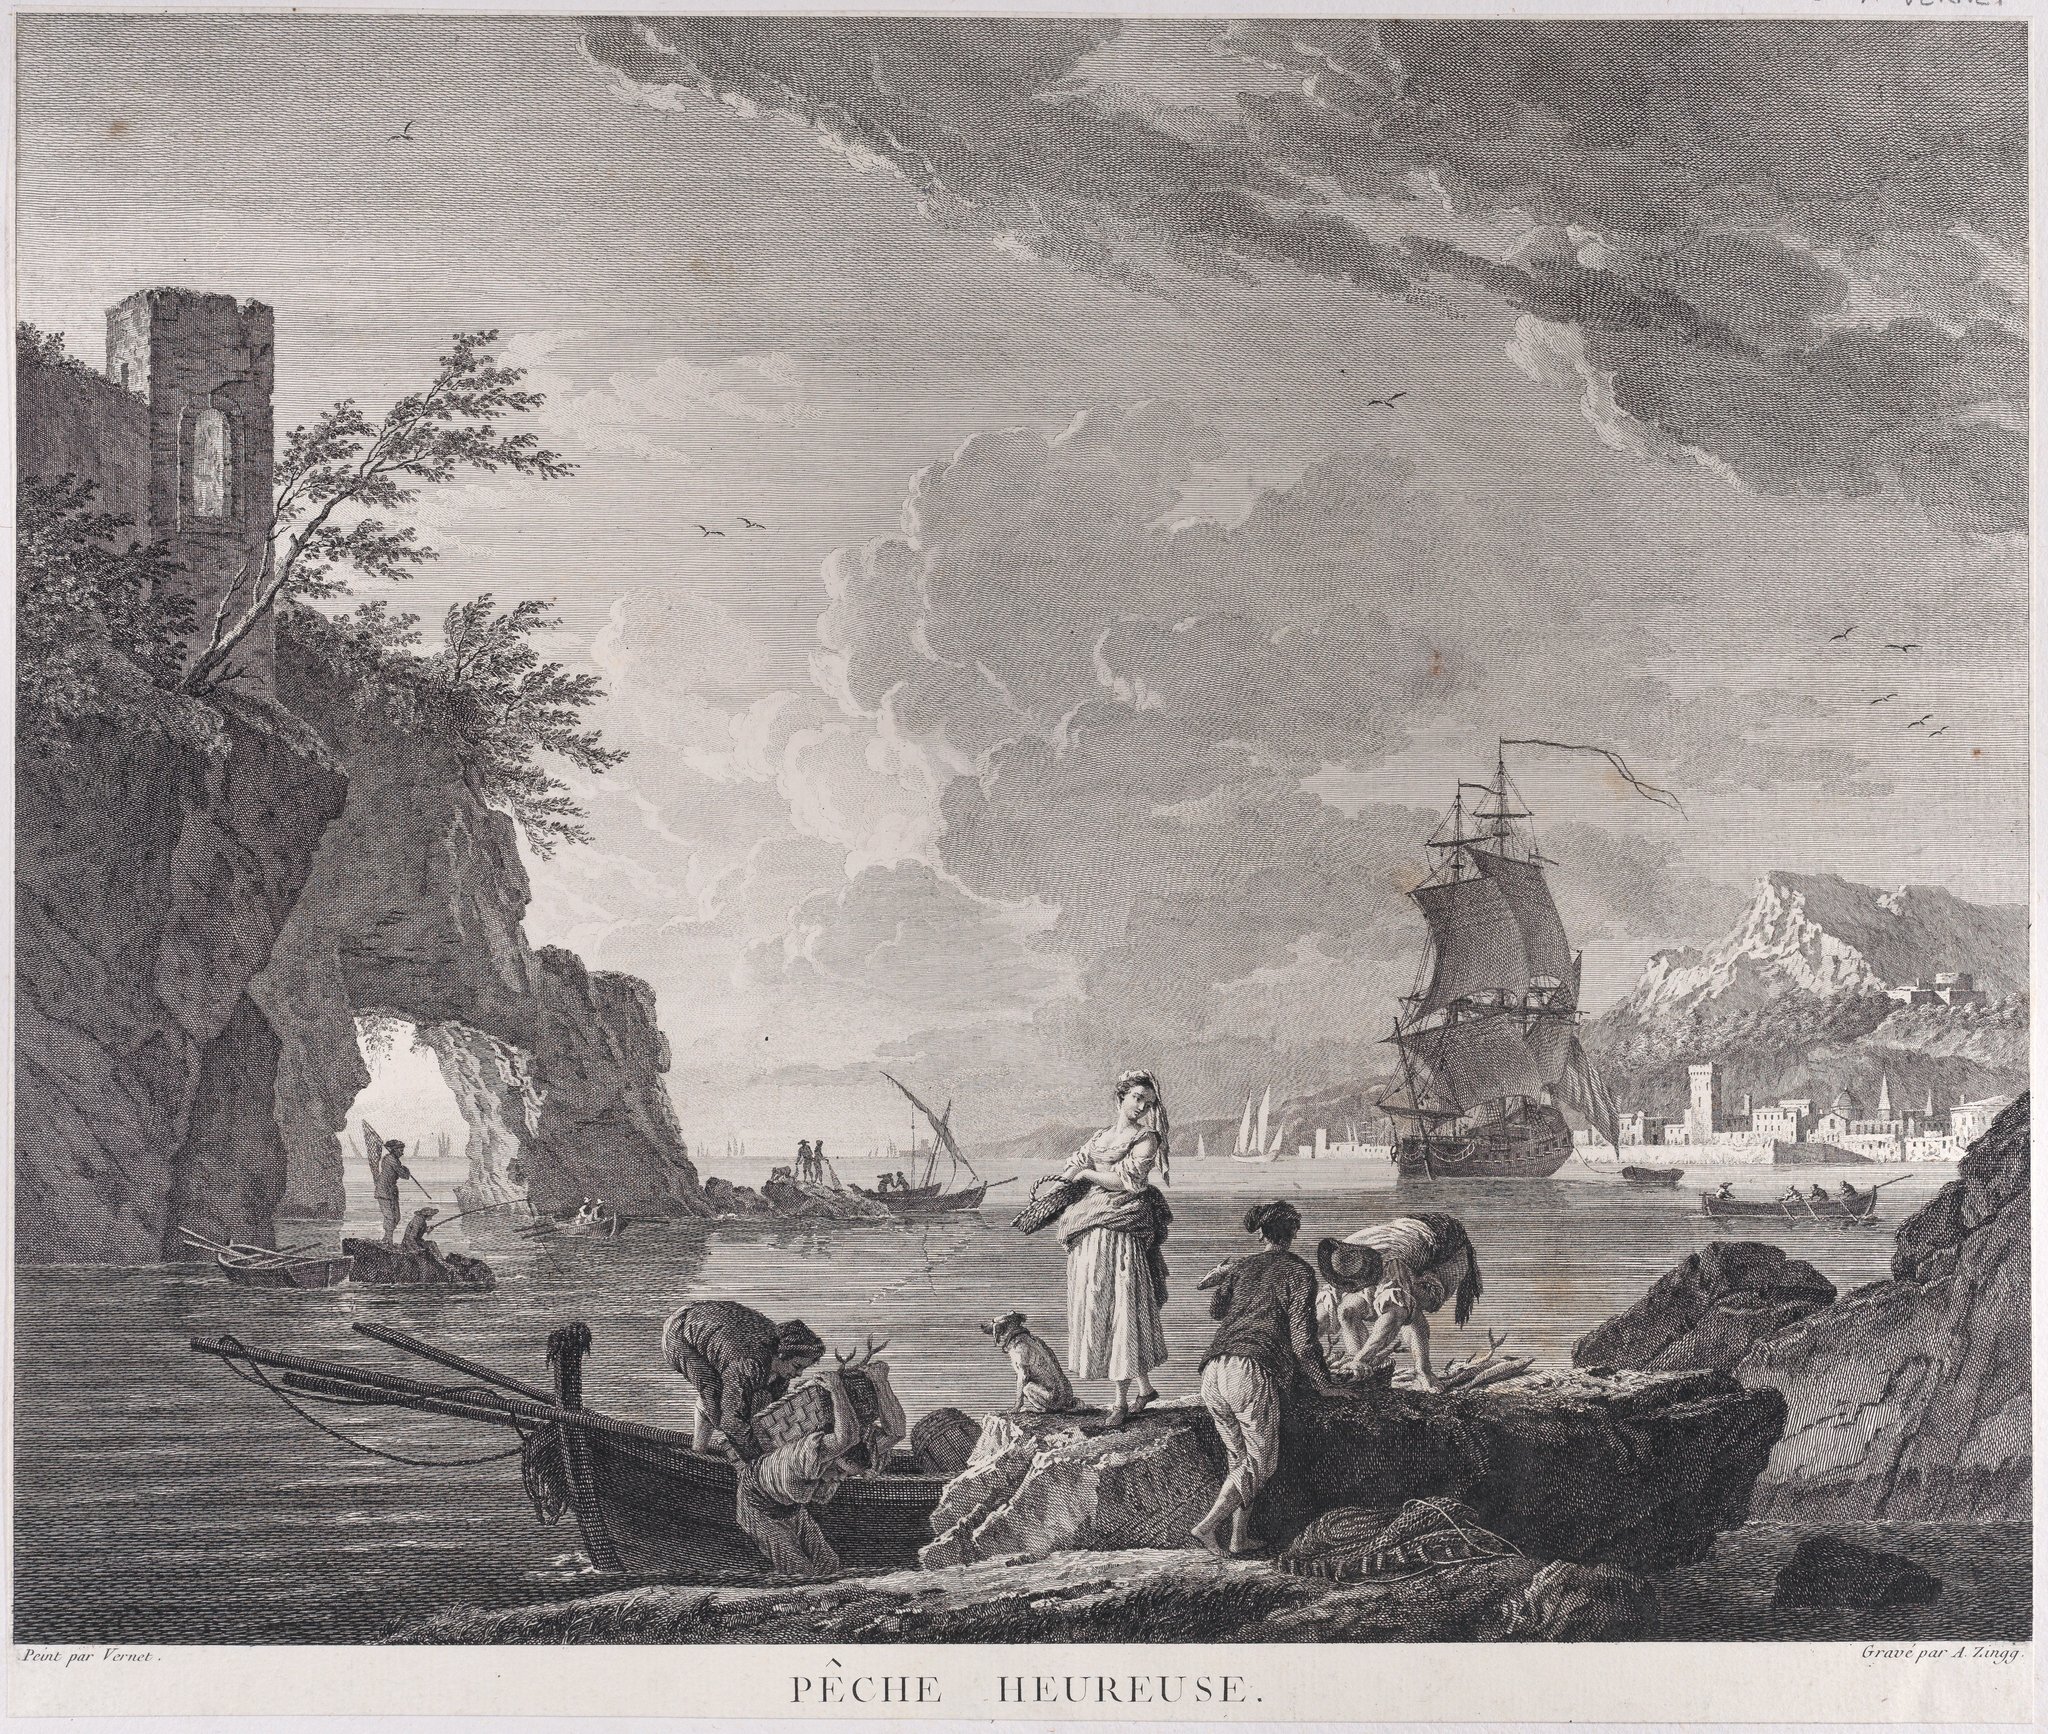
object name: print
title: Happy Fishing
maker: joseph vernet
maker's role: artist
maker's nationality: french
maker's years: 1714-1789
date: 1760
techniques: engraving